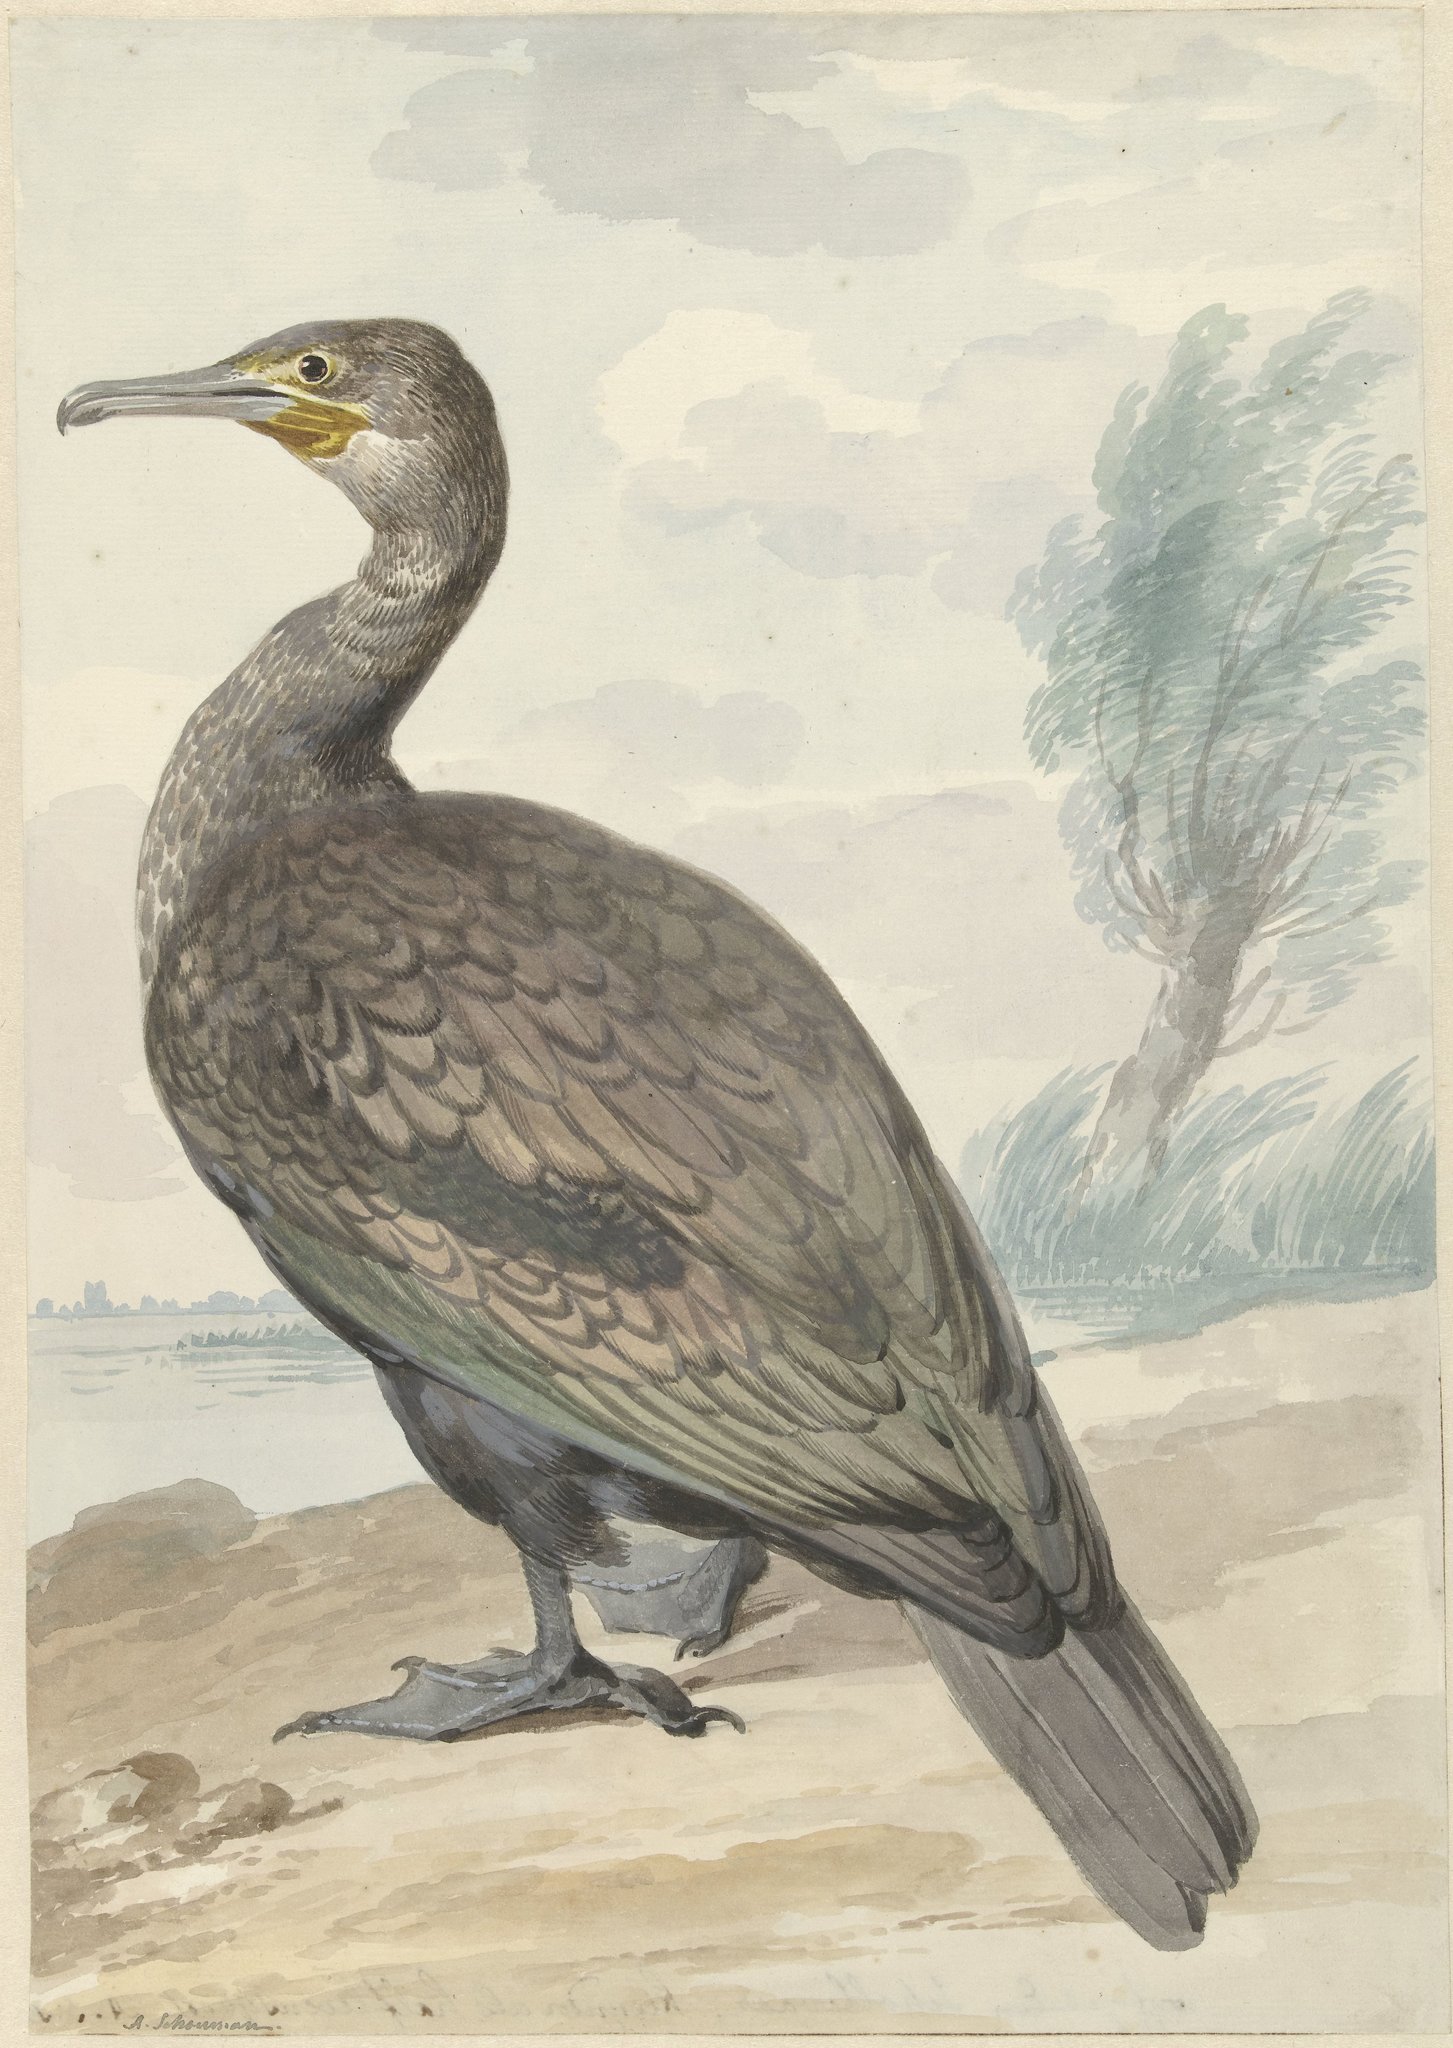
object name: watercolor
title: Aalscholver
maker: aert schouman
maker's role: draughtsman, painter, print maker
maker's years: 1710-1792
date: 1720-1792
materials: paper, watercolor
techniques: brush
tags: water-birds: cormorant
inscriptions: inscription: ‘wijfjes Een Schollevaar, kleijnder als halflevensgroot A. S. 17[..]’